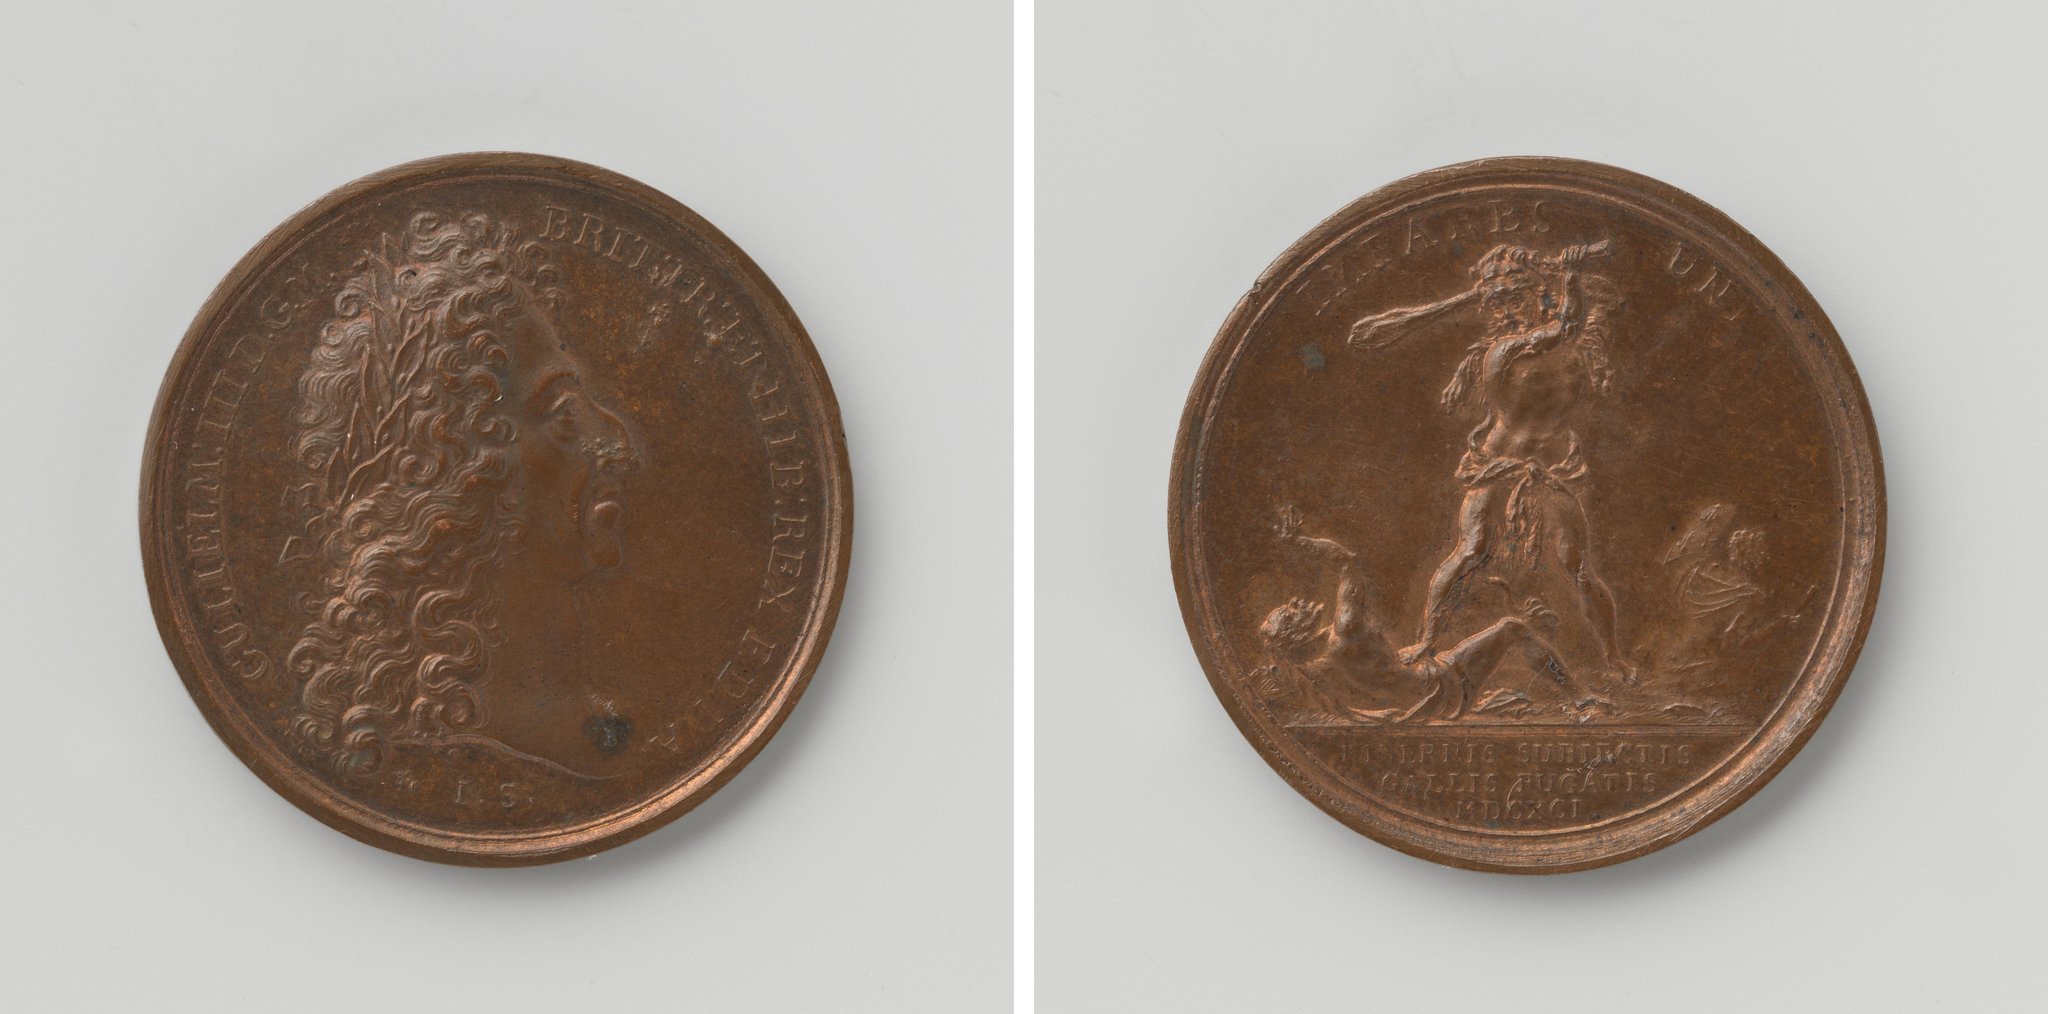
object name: history medal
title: Overwinning bij Aghrim, behaald tijdens de afwezigheid van Willem III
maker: jan smeltzing (i)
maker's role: modelleur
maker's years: 1656-1693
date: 1691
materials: bronze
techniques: striking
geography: leiden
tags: the hague, william iii (prince of orange and king of england, scotland, and ireland)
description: Bronzen penning. Voorzijde: borststuk man met lauwerkrans binnen omschrift. Keerzijde: Hercules velt met zijn knots Ierland terwijl een Frans soldaat wegvlucht binnen omschrift; afsnede: opschrift